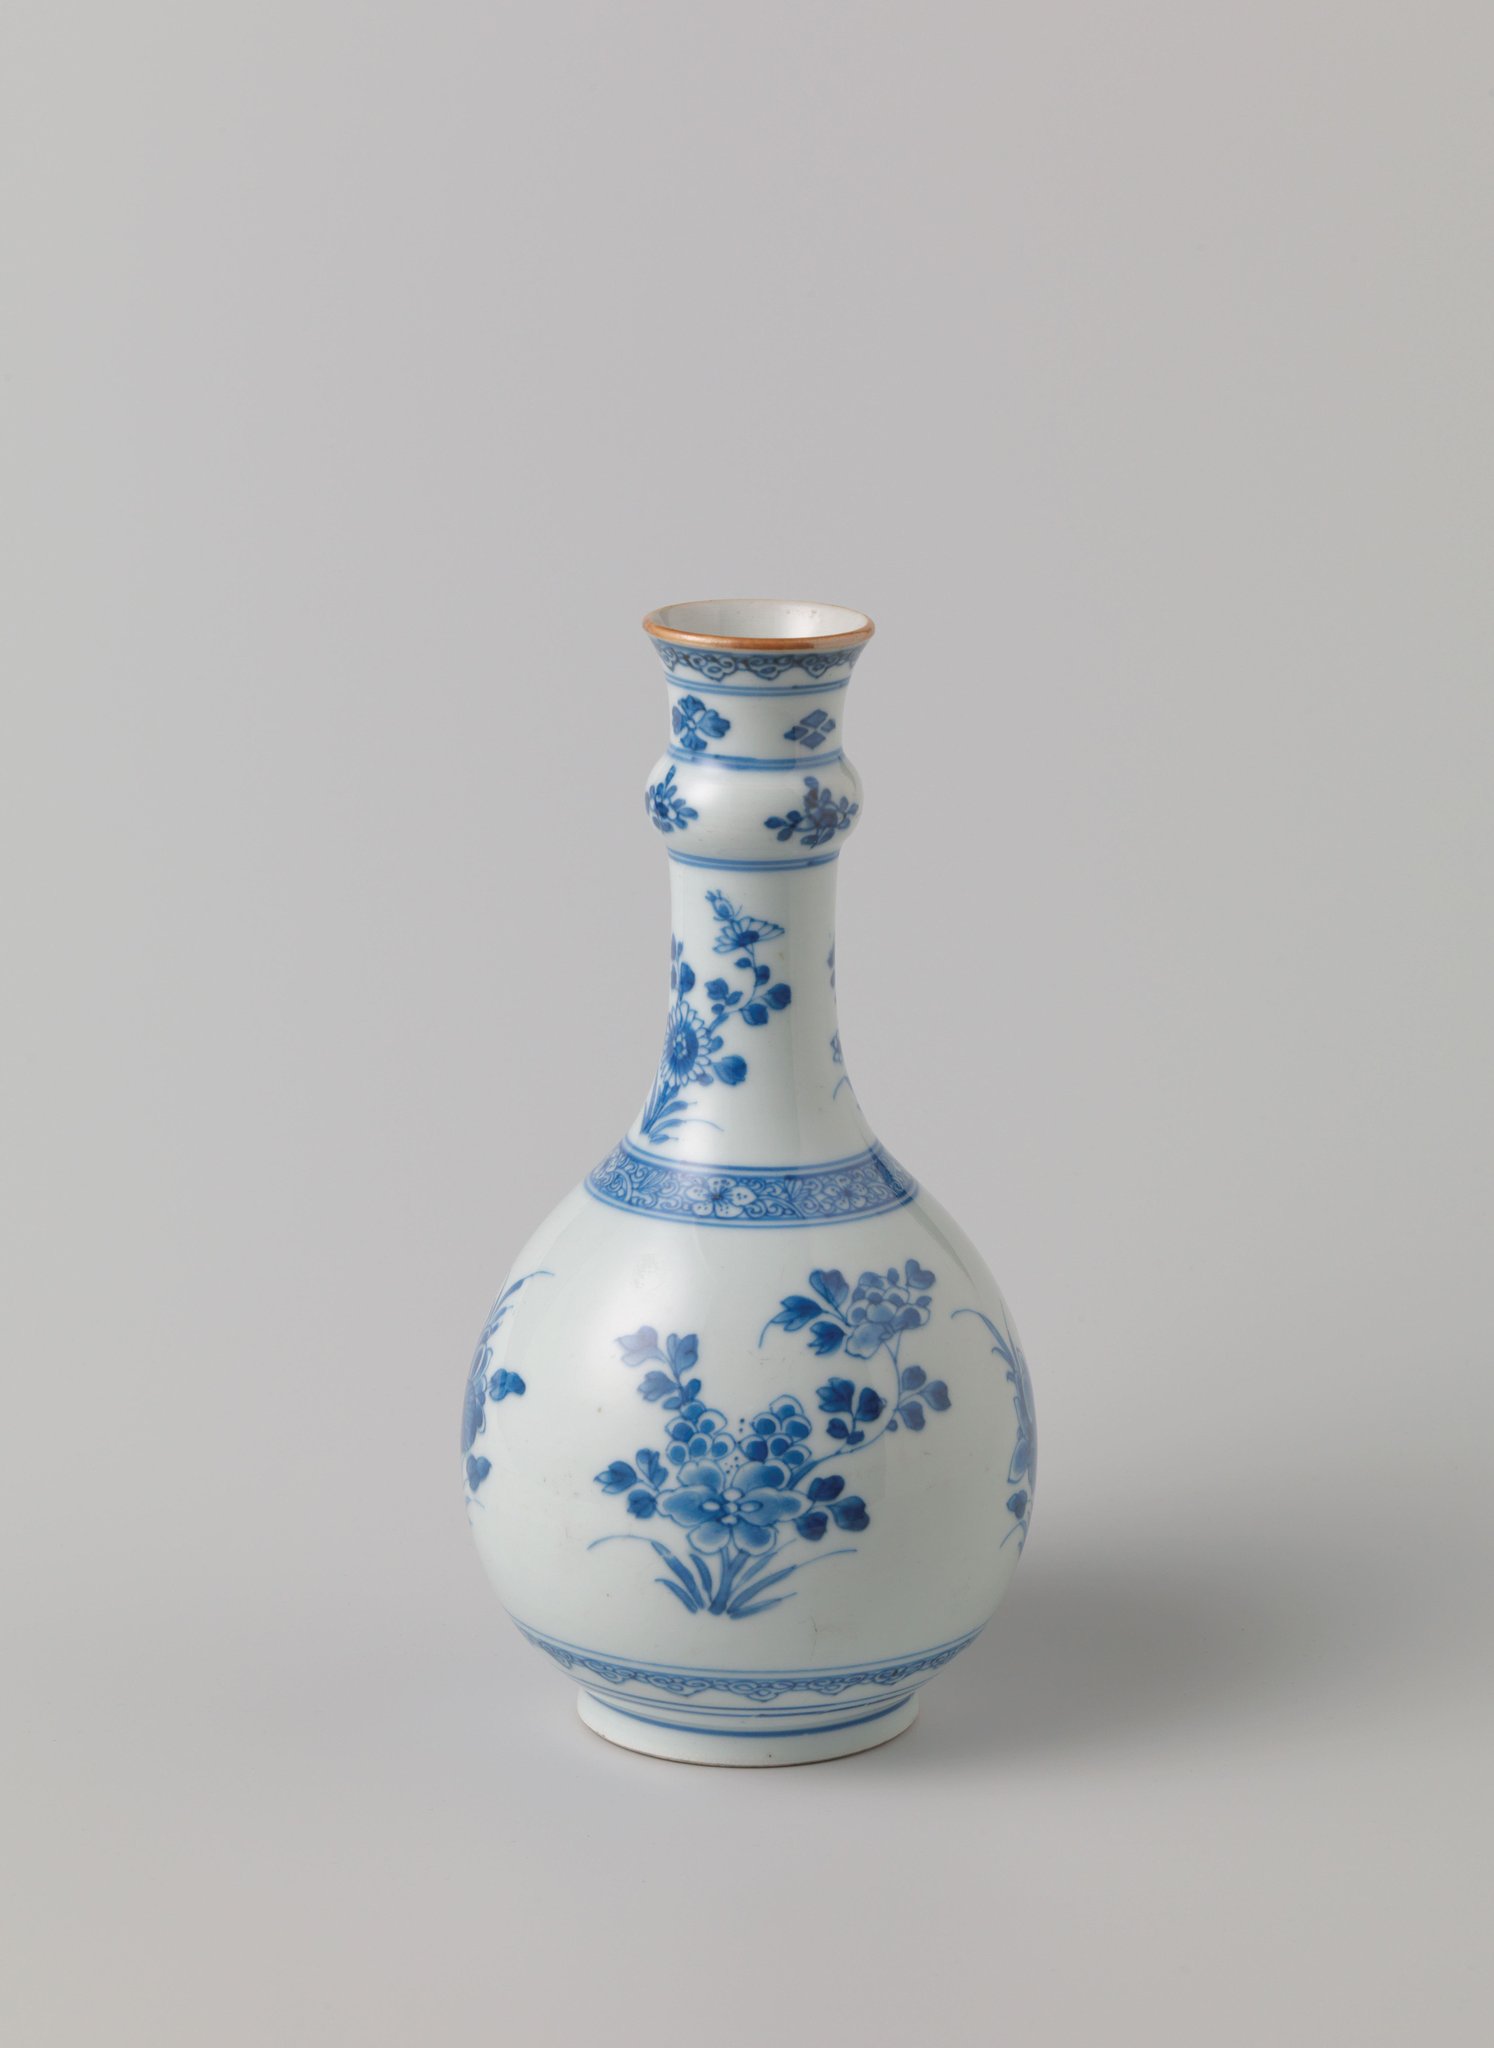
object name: bottle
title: Pear-shaped bottle vase with flowering plants and floral scrolls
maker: Anonymous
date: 1700-1724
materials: cobalt, glaze, paint, porcelain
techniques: firing, turning, vitrification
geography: china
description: AK-NM-6714 Vaas • Blauw-wit Kangxi-porselein • Onderdeel van Royers porseleincollectie • Oorspronkelijk vier exemplaren (inventaris Van der Kellen 1876) Bij de bespreking van een aantal vazen, klaag ik dat ik geen harmonie kan ontdekken in de organisatie van de decoratie (zie bijvoorbeeld AK-NM-6800). Hier (bij dit vaasje AK-NM-6714) heerst de logica (en daarom ook de verveling?). Het is in de bespreking van AK-NM-6800 mijn veronderstelling dat de wildernis aan decoratiemotieven ontstond door de ingewikkelde communicatie tussen porseleinproducenten en de Europese kopers die langzamerhand iets anders wilden, zelf nog niet precies wisten wat en dat ‘nieuwe idee’ met enige moeite probeerden over te brengen door elementen aan te wijzen die wél of niet bevielen. Is dit vaasje dan van ná de chaos? Mogelijk. Waarschijnlijk! Alles is netjes, afgewogen, en vrij pretentieloos. Het kan moeiteloos op een Marot-schoorsteen staan. Sterker nog, de fles komt vrij exact overeen met twee stellen flessen geschilderd door Pieter Jansz. Van Ruijven (1650-1719): een bovendeurstuk dat een porseleinopstelling voorstelt, gedateerd 1719 [Baarsen et al. 1988, nr. 179]. De opstelling en ook het porselein is sterk verwant aan de prenten van Daniël Marot. De flessen van Van Ruijven hebben, net als deze vaas de brede witte baan op de buik met daarin een aantal bloeiende planten tegen overvloedig wit in de achtergrond. Boven en onder wordt deze baan besloten door een smalle decoratieve band. En de hals heeft weer een aantal bloemtakken. Twee van Van Ruijvens vazen hebben weliswaar niet de verdikking in de hals, maar wel een brede, geprononceerde opstaande mondrand, waardoor er ook in dit opzicht sprake is van een opmerkelijke overeenkomst. Voor de vorm, de verdikking onder de mond, bestaat geen verklaring. Jörg merkt op dat flessen met dergelijke fantasievolle vormen geliefd waren voor de porseleinopstellingen [Jörg 1997, nr. 140]. Dat zal zeker waar zijn. Een identiek exemplaar bevindt zich in het Topkapi-museum [Krahl en Ayers 1986, Vol. III, nr. 2386]. Bronnen: Regina Krahl en John Ayers, Chinese ceramics in the Topkapi Saray Museum, Istanbul: a complete catalogue, Londen, 1986. Reinier Baarsen et al., Courts and Colonies. The William and Mary Style in Holland, England and America (tent.cat. Cooper-Hewitt Museum etc.), Seattle/Londen, 1988. Christiaan J.A. Jörg, Chinese ceramics in the collection of the Rijksmuseum, Amsterdam: the Ming and Qing dynasties, Londen, 1997.